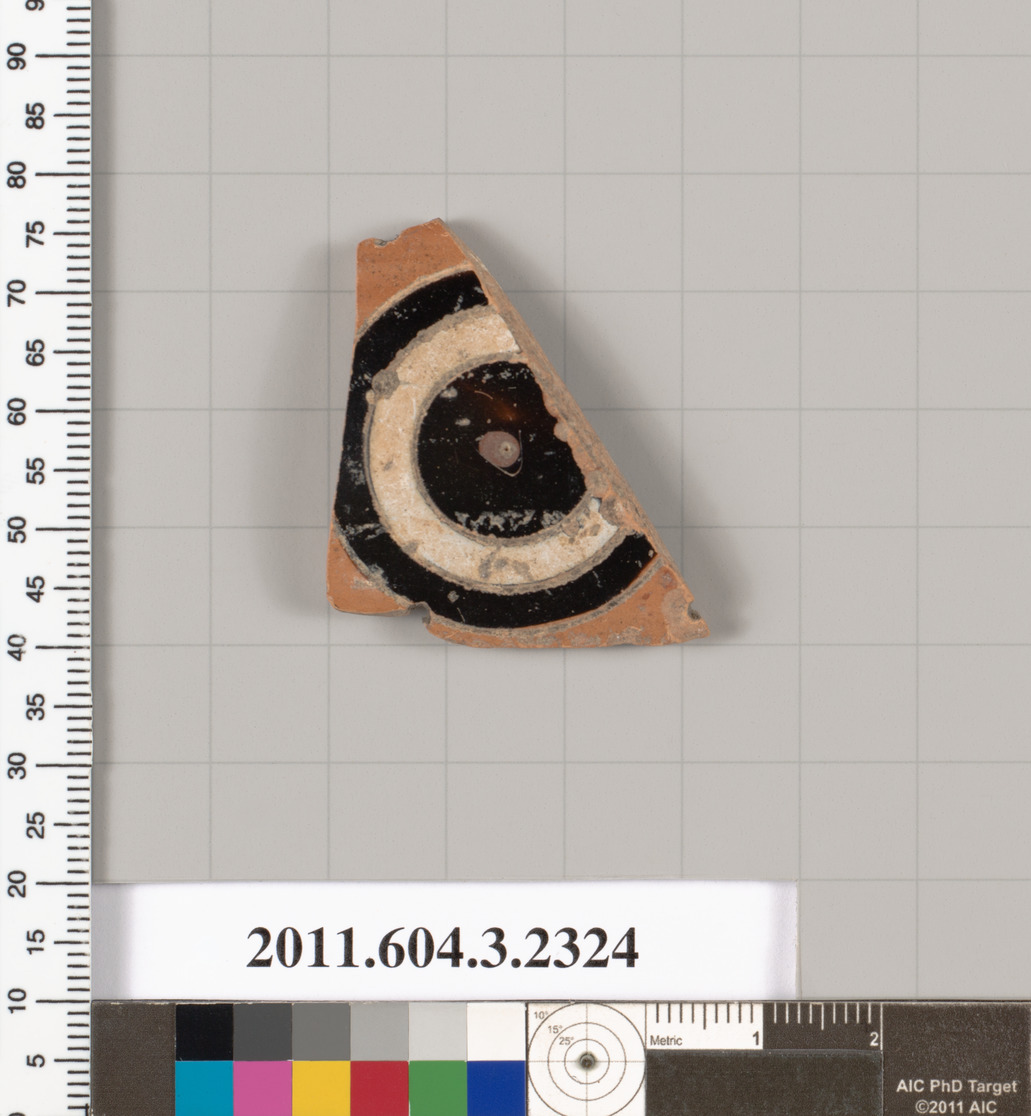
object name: kylix fragment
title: Terracotta fragment of a kylix: eye-cup (drinking cup)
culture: greek, attic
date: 530-520 BCE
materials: terracotta